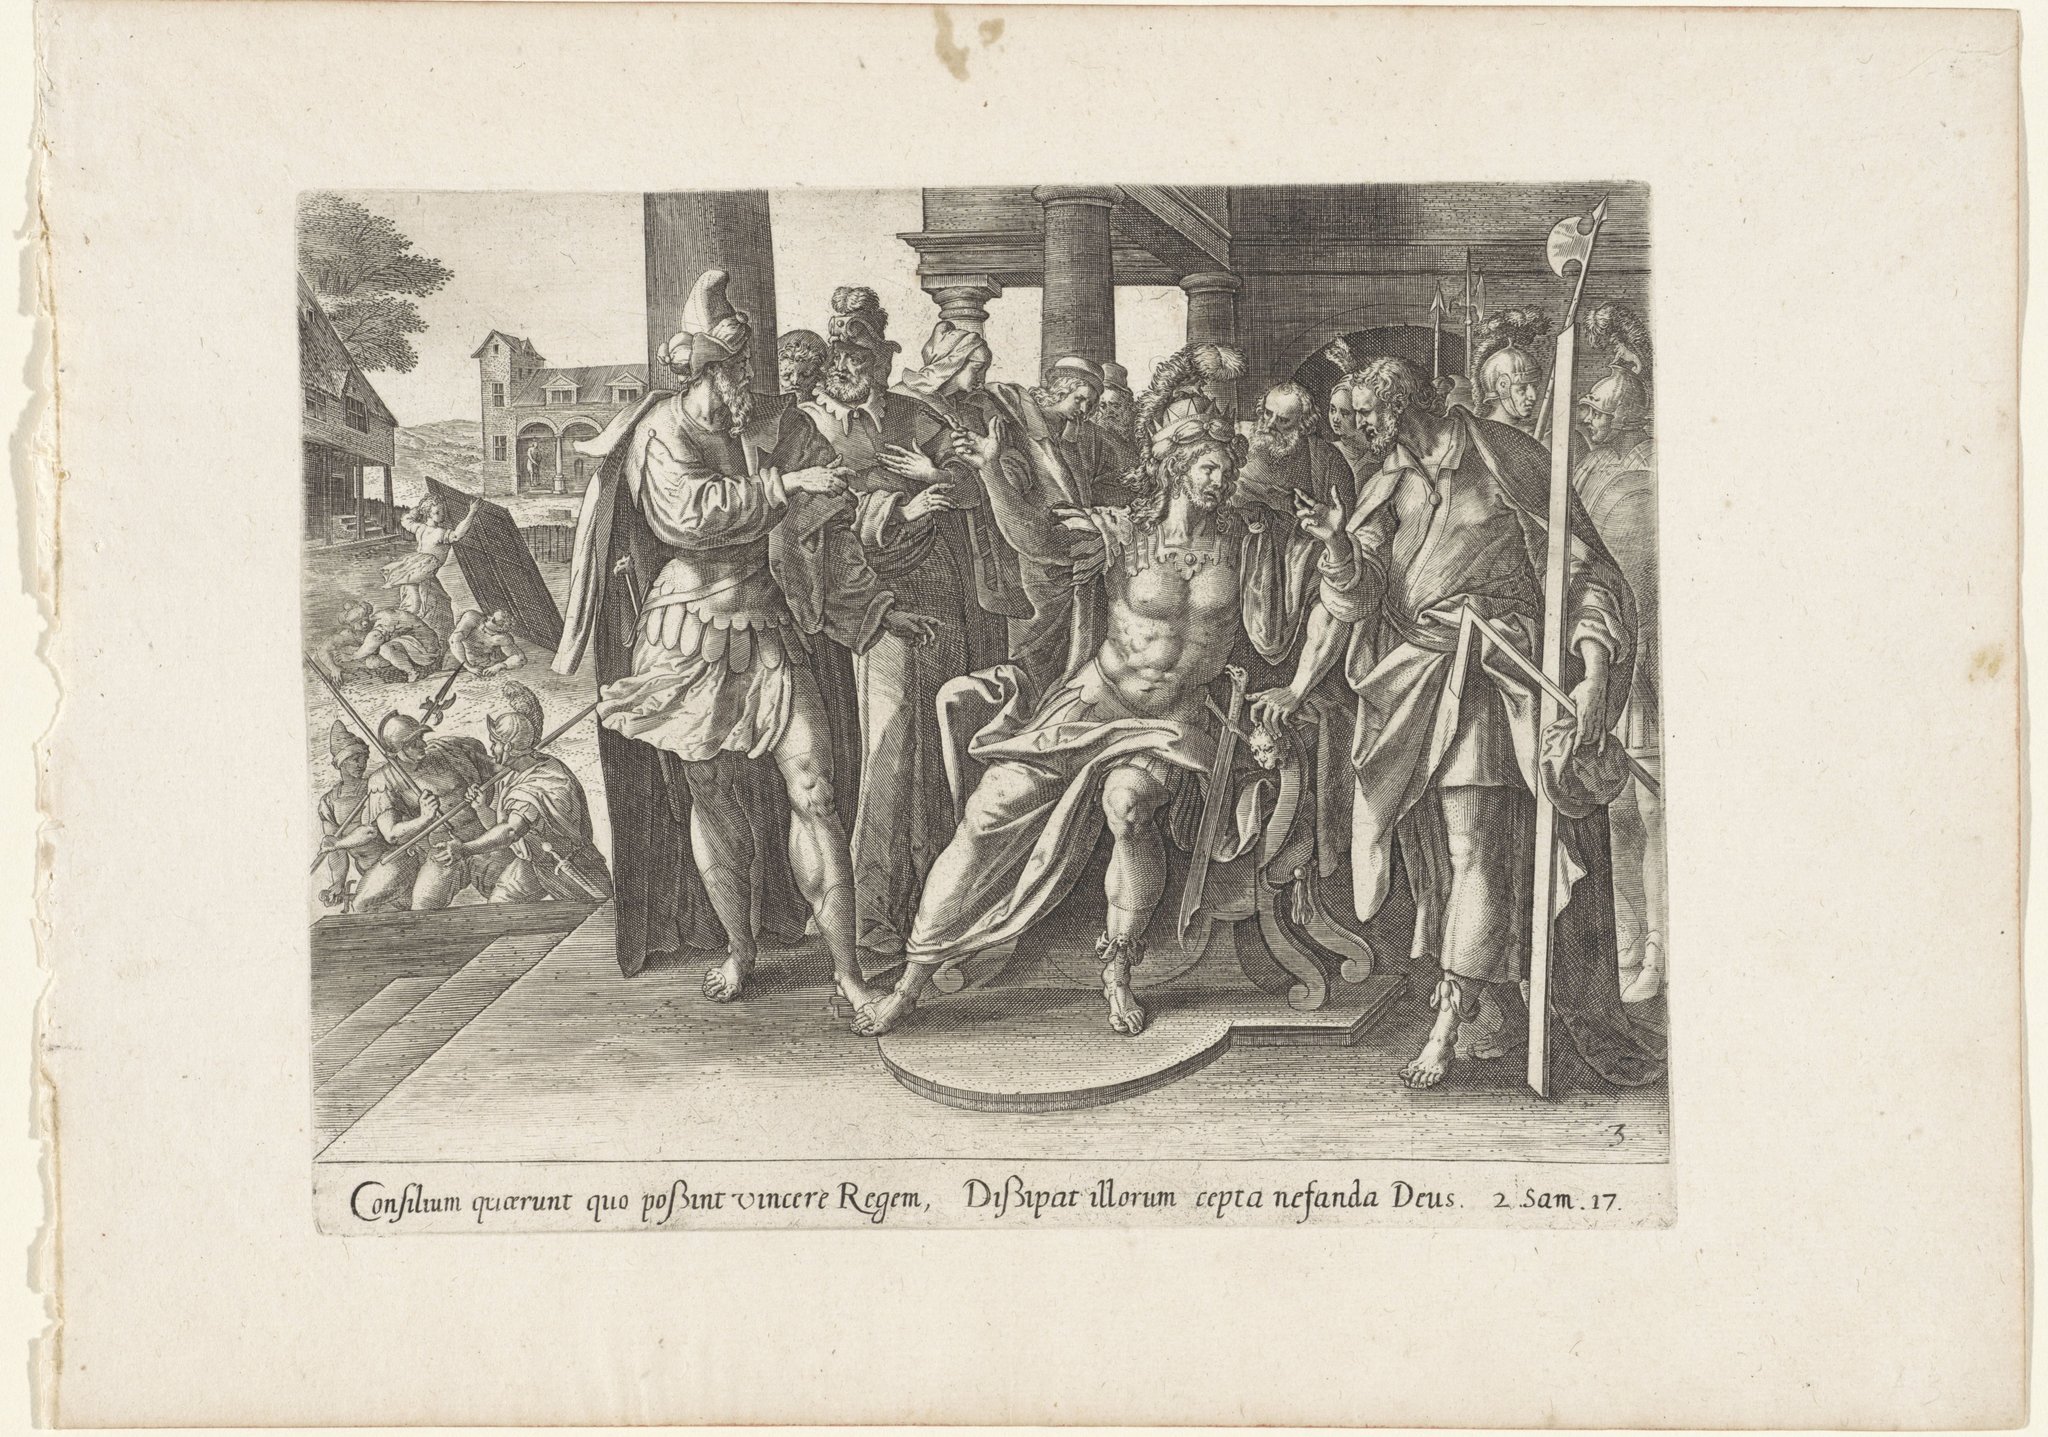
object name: print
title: Geschiedenis van David en Absalom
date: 1585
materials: paper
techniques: engraving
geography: antwerp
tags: pursued by absalom's soldiers ahimaaz and jonathan hide in a pit in a house at baharim; a woman spreads a cover with corn over the pit, hushai called for counsel, absalom takes counsel with ahitophel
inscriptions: collector's mark: Lugt 2760, collector's mark: Lugt 2228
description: Achitofel en de Arkiet Chusai adviseren Absalom over het krijgsplan tegen koning David. Op de achtergrond verstoppen Jonatan en Achimaäs - die het nieuws over het plan aan koning David zouden overbrengen - zich in een put op het erf van het huis van een man uit Bachurim. Diens vrouw legt een luik over de opening van de put, zodat er niets te zien is. Onder de voorstelling een verwijzing in het Latijn naar de Bijbeltekst in 2 Sam. 17.